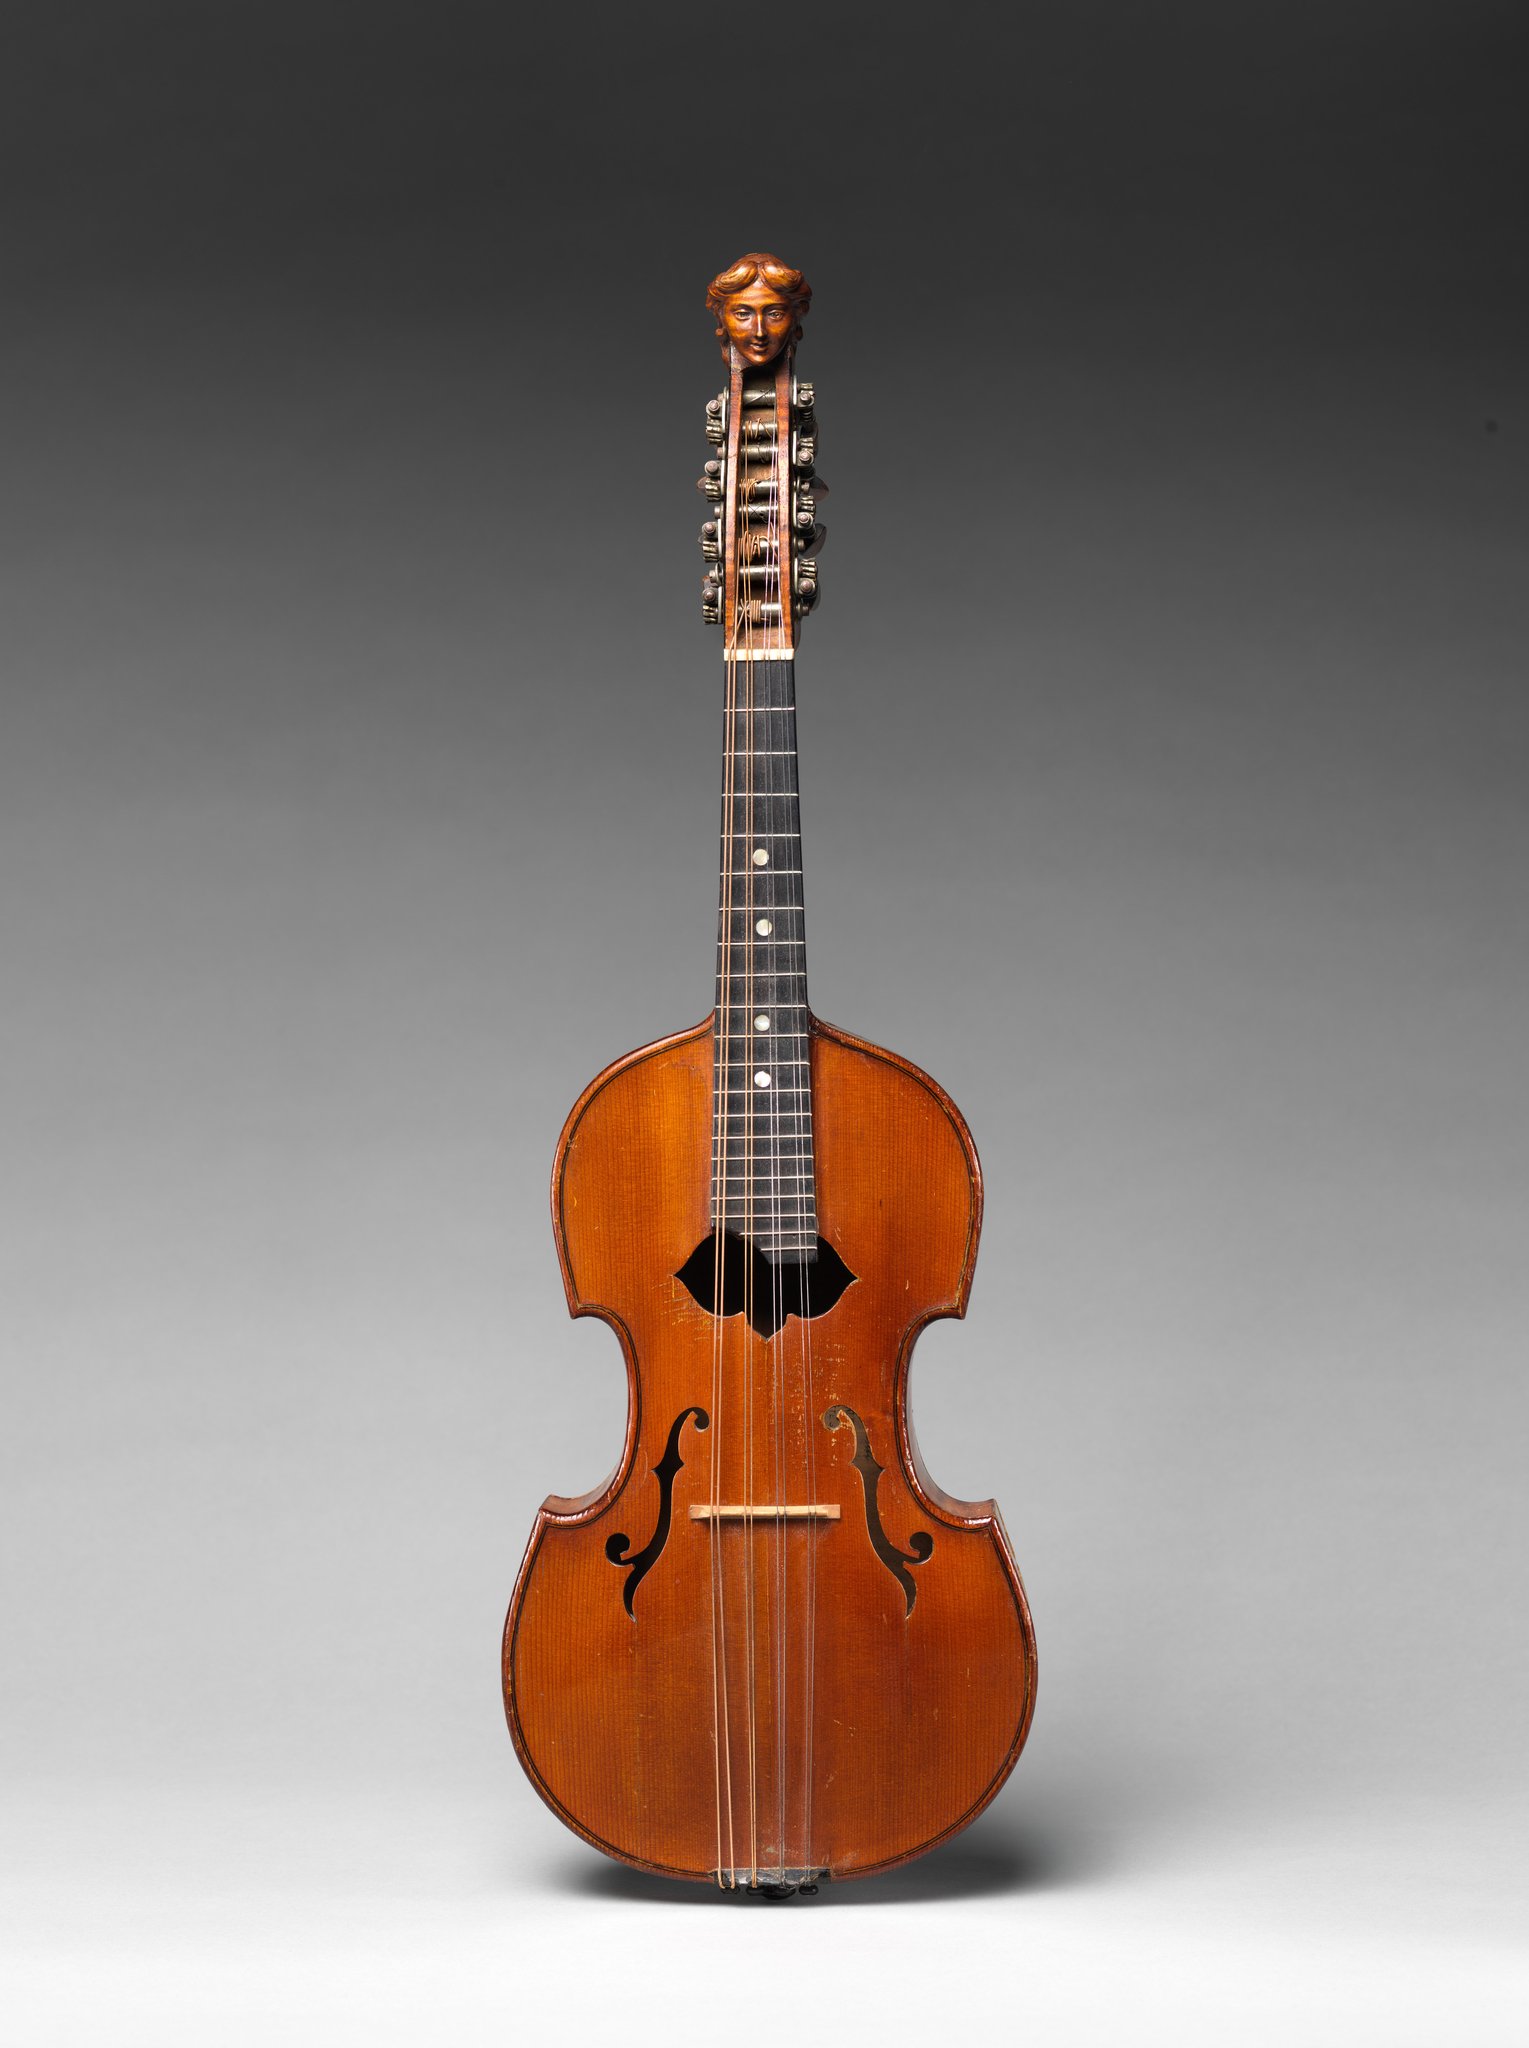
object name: arnolo violaline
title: Arnolo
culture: french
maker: georges contal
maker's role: maker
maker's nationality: french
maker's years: 1874-1915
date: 1901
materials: wood, metal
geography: france